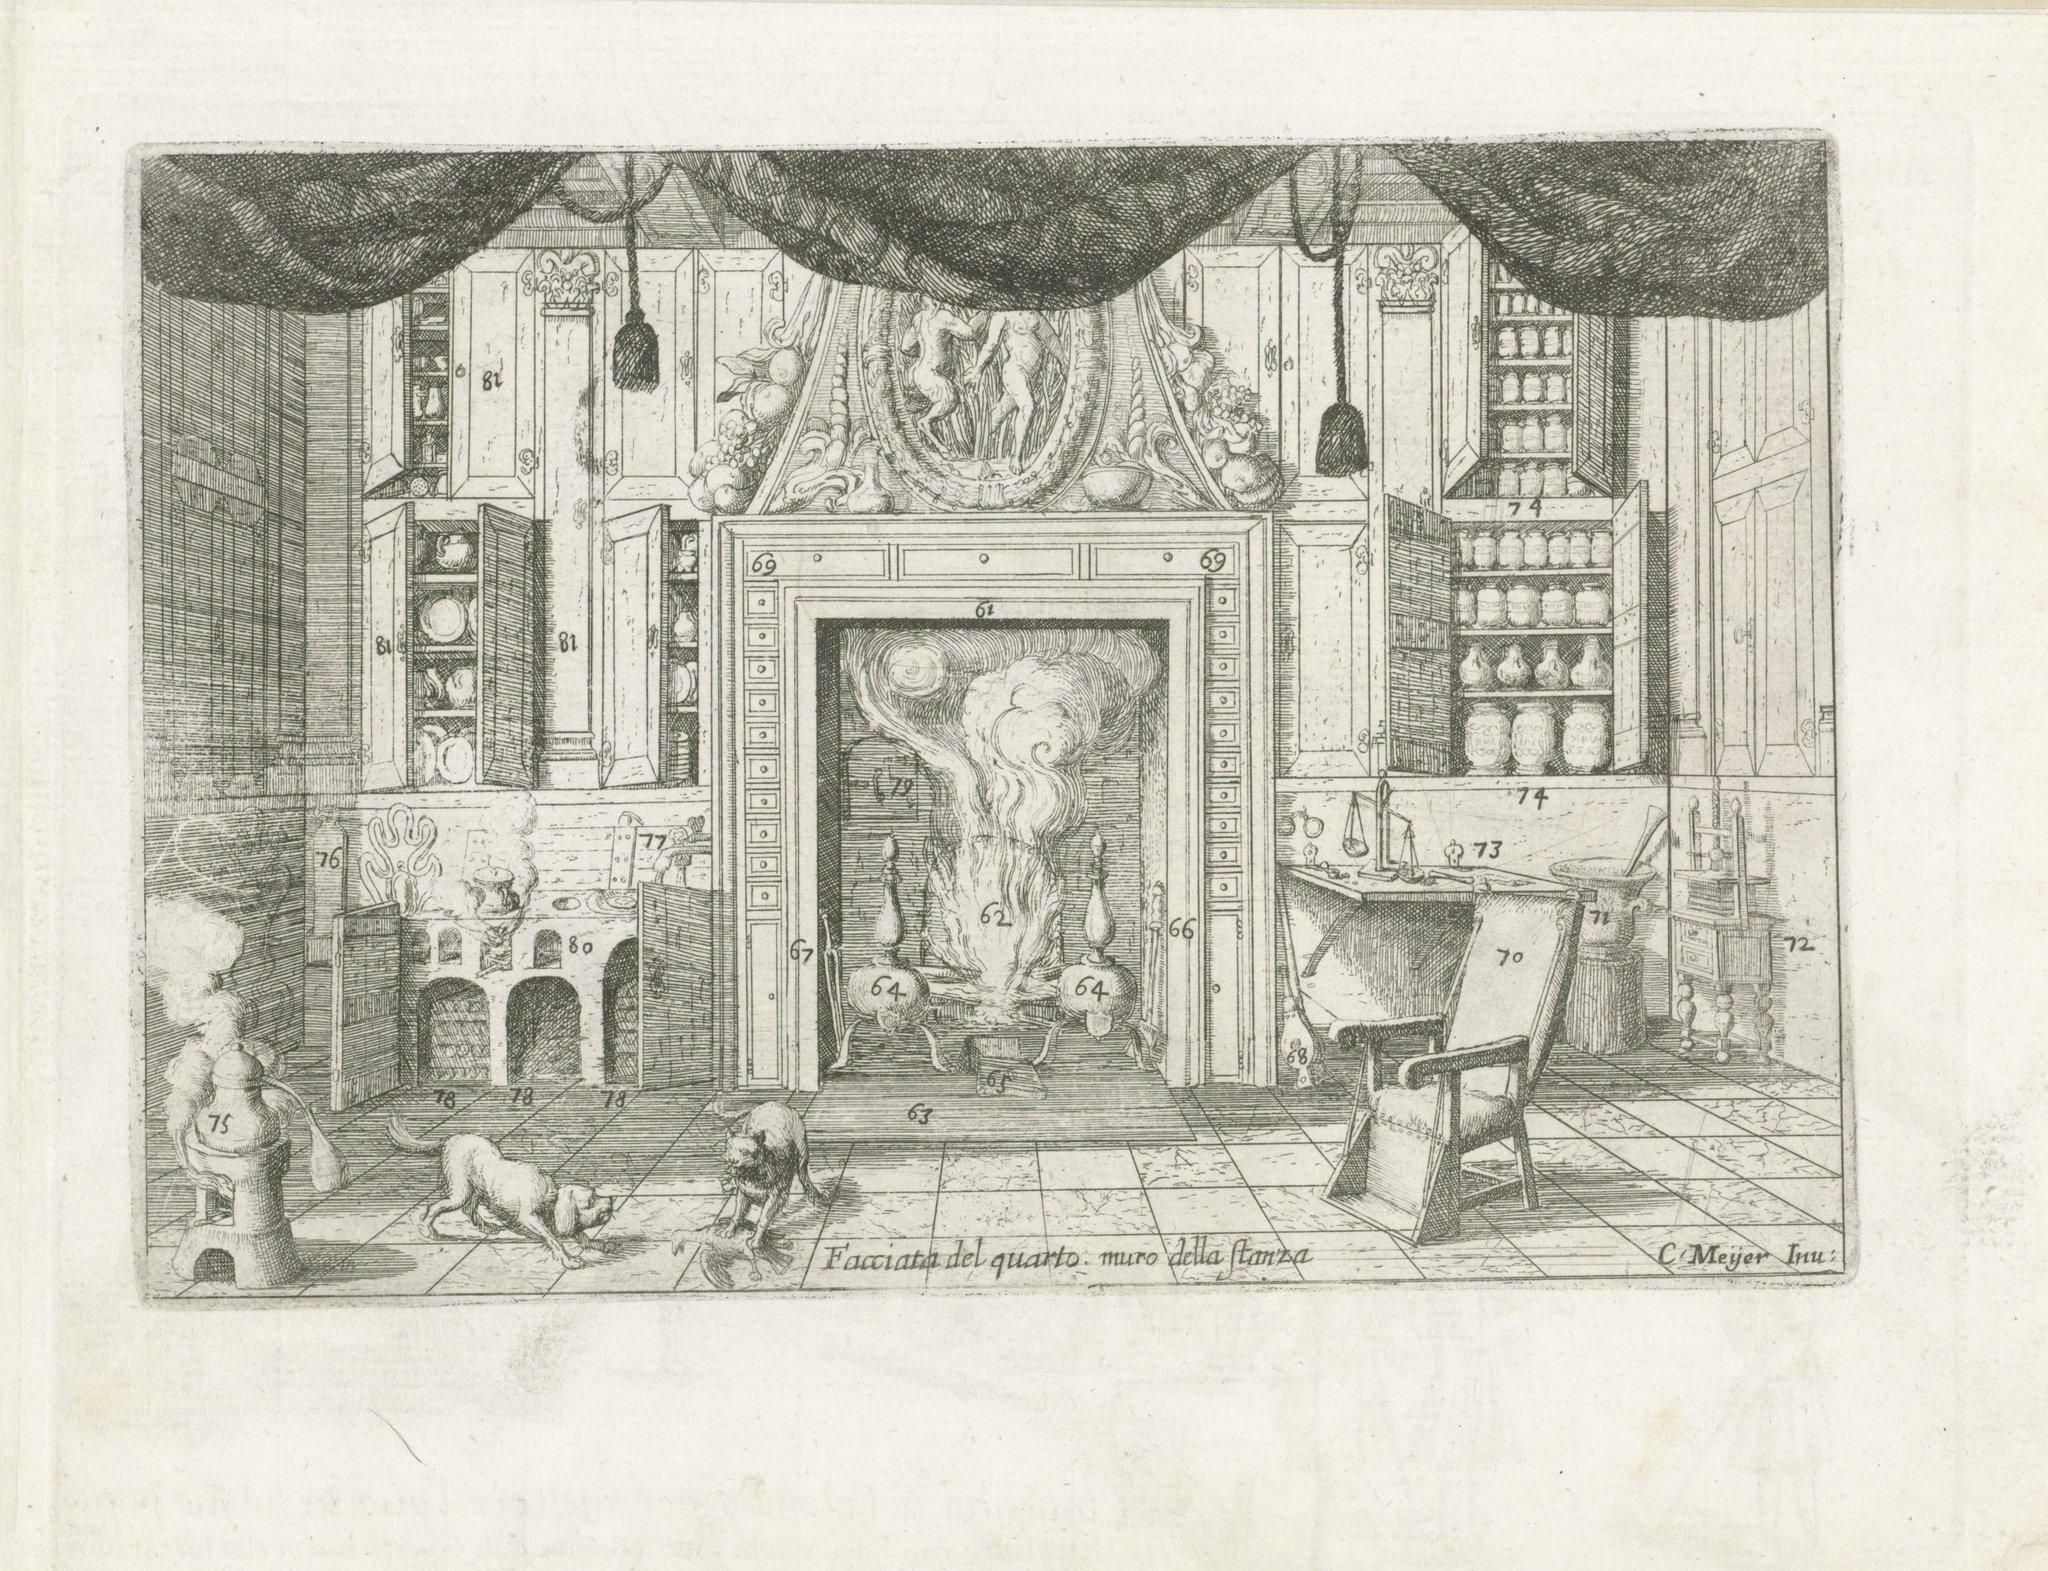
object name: print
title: Racolta di varii segreti come si vedono nelle segventi figure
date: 1696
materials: paper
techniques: etching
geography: rome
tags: cat, open hearth, fire-place, interior of the house, dog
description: Prent uit: Meyer, Cornelis. L'arte di rendere i fiumi navigabili in varii modi, con altre nuova inuentioni, e varij segreti : Divisa in tre parti : con tre Tauole in lingua Latina, Francese, e Ollandese. Roma : Gio Giac. Komarek Boëmo, 1696.